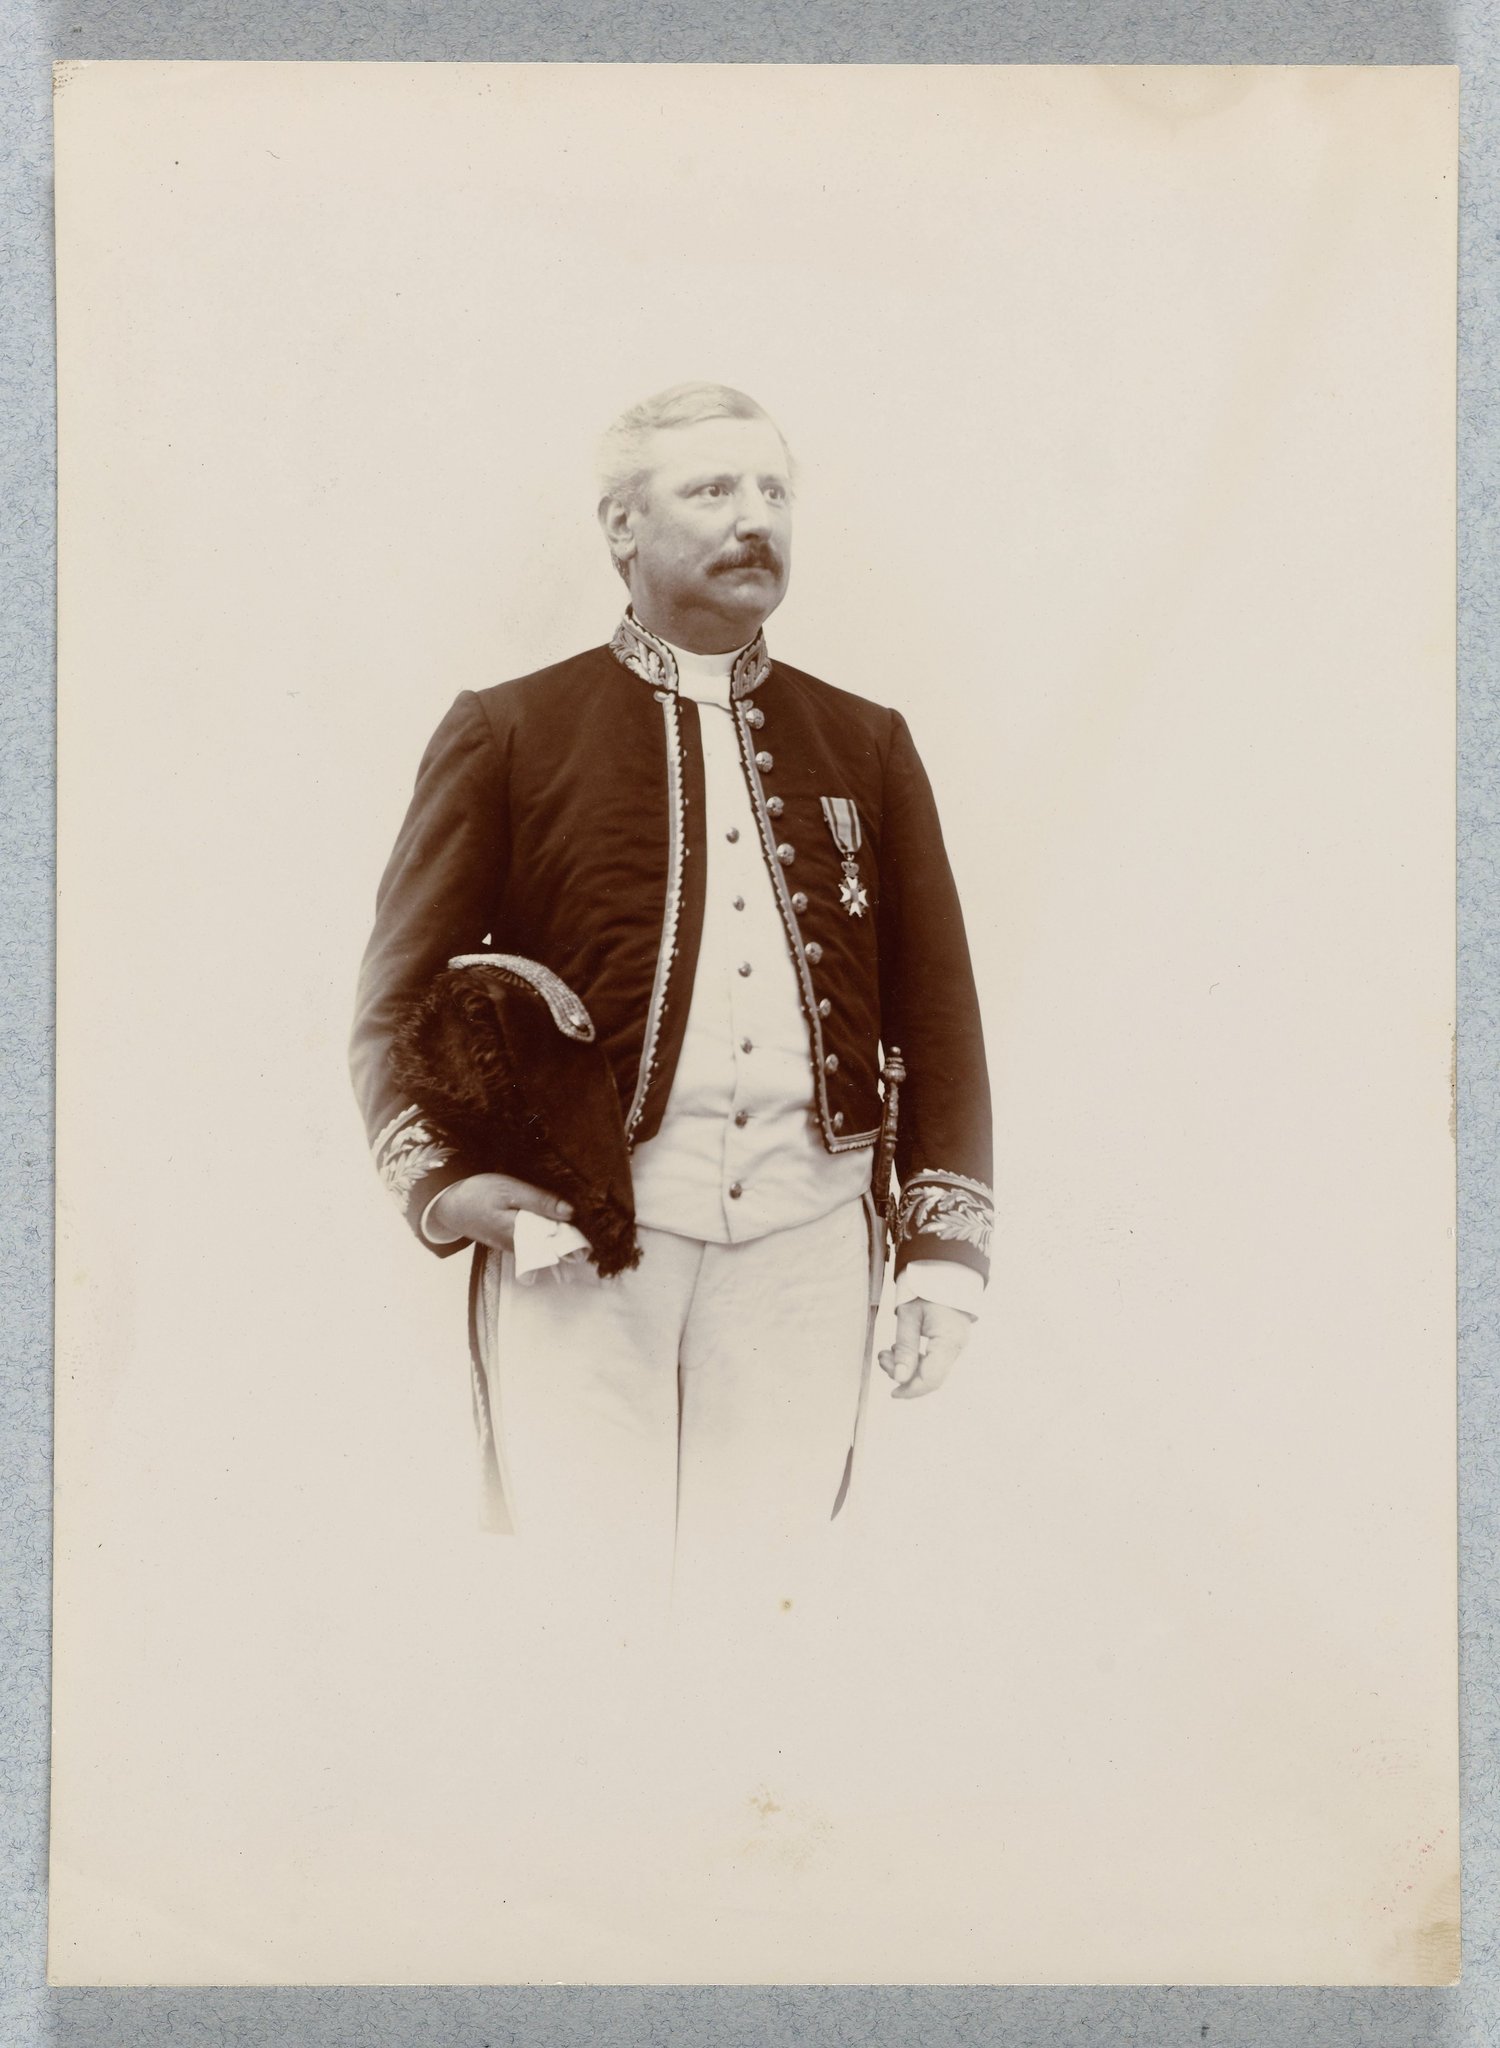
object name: photograph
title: Jhr. Mr. T.A.J. van Asch van Wijck / Gouverneur van Suriname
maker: théodore van lelyveld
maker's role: painter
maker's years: 1867-1954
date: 1895-1898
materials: photographic support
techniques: collodion silver print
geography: suriname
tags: utrecht, the hague, colonial governor, historical persons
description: Portret van Titus van Asch van Wijck, gouverneur van Suriname. Kniestuk, staande met de steek in de rechterhand. Losse fotoafdruk in een fotoalbum van Théodore van Lelyveld over Suriname uit 1895-1898.